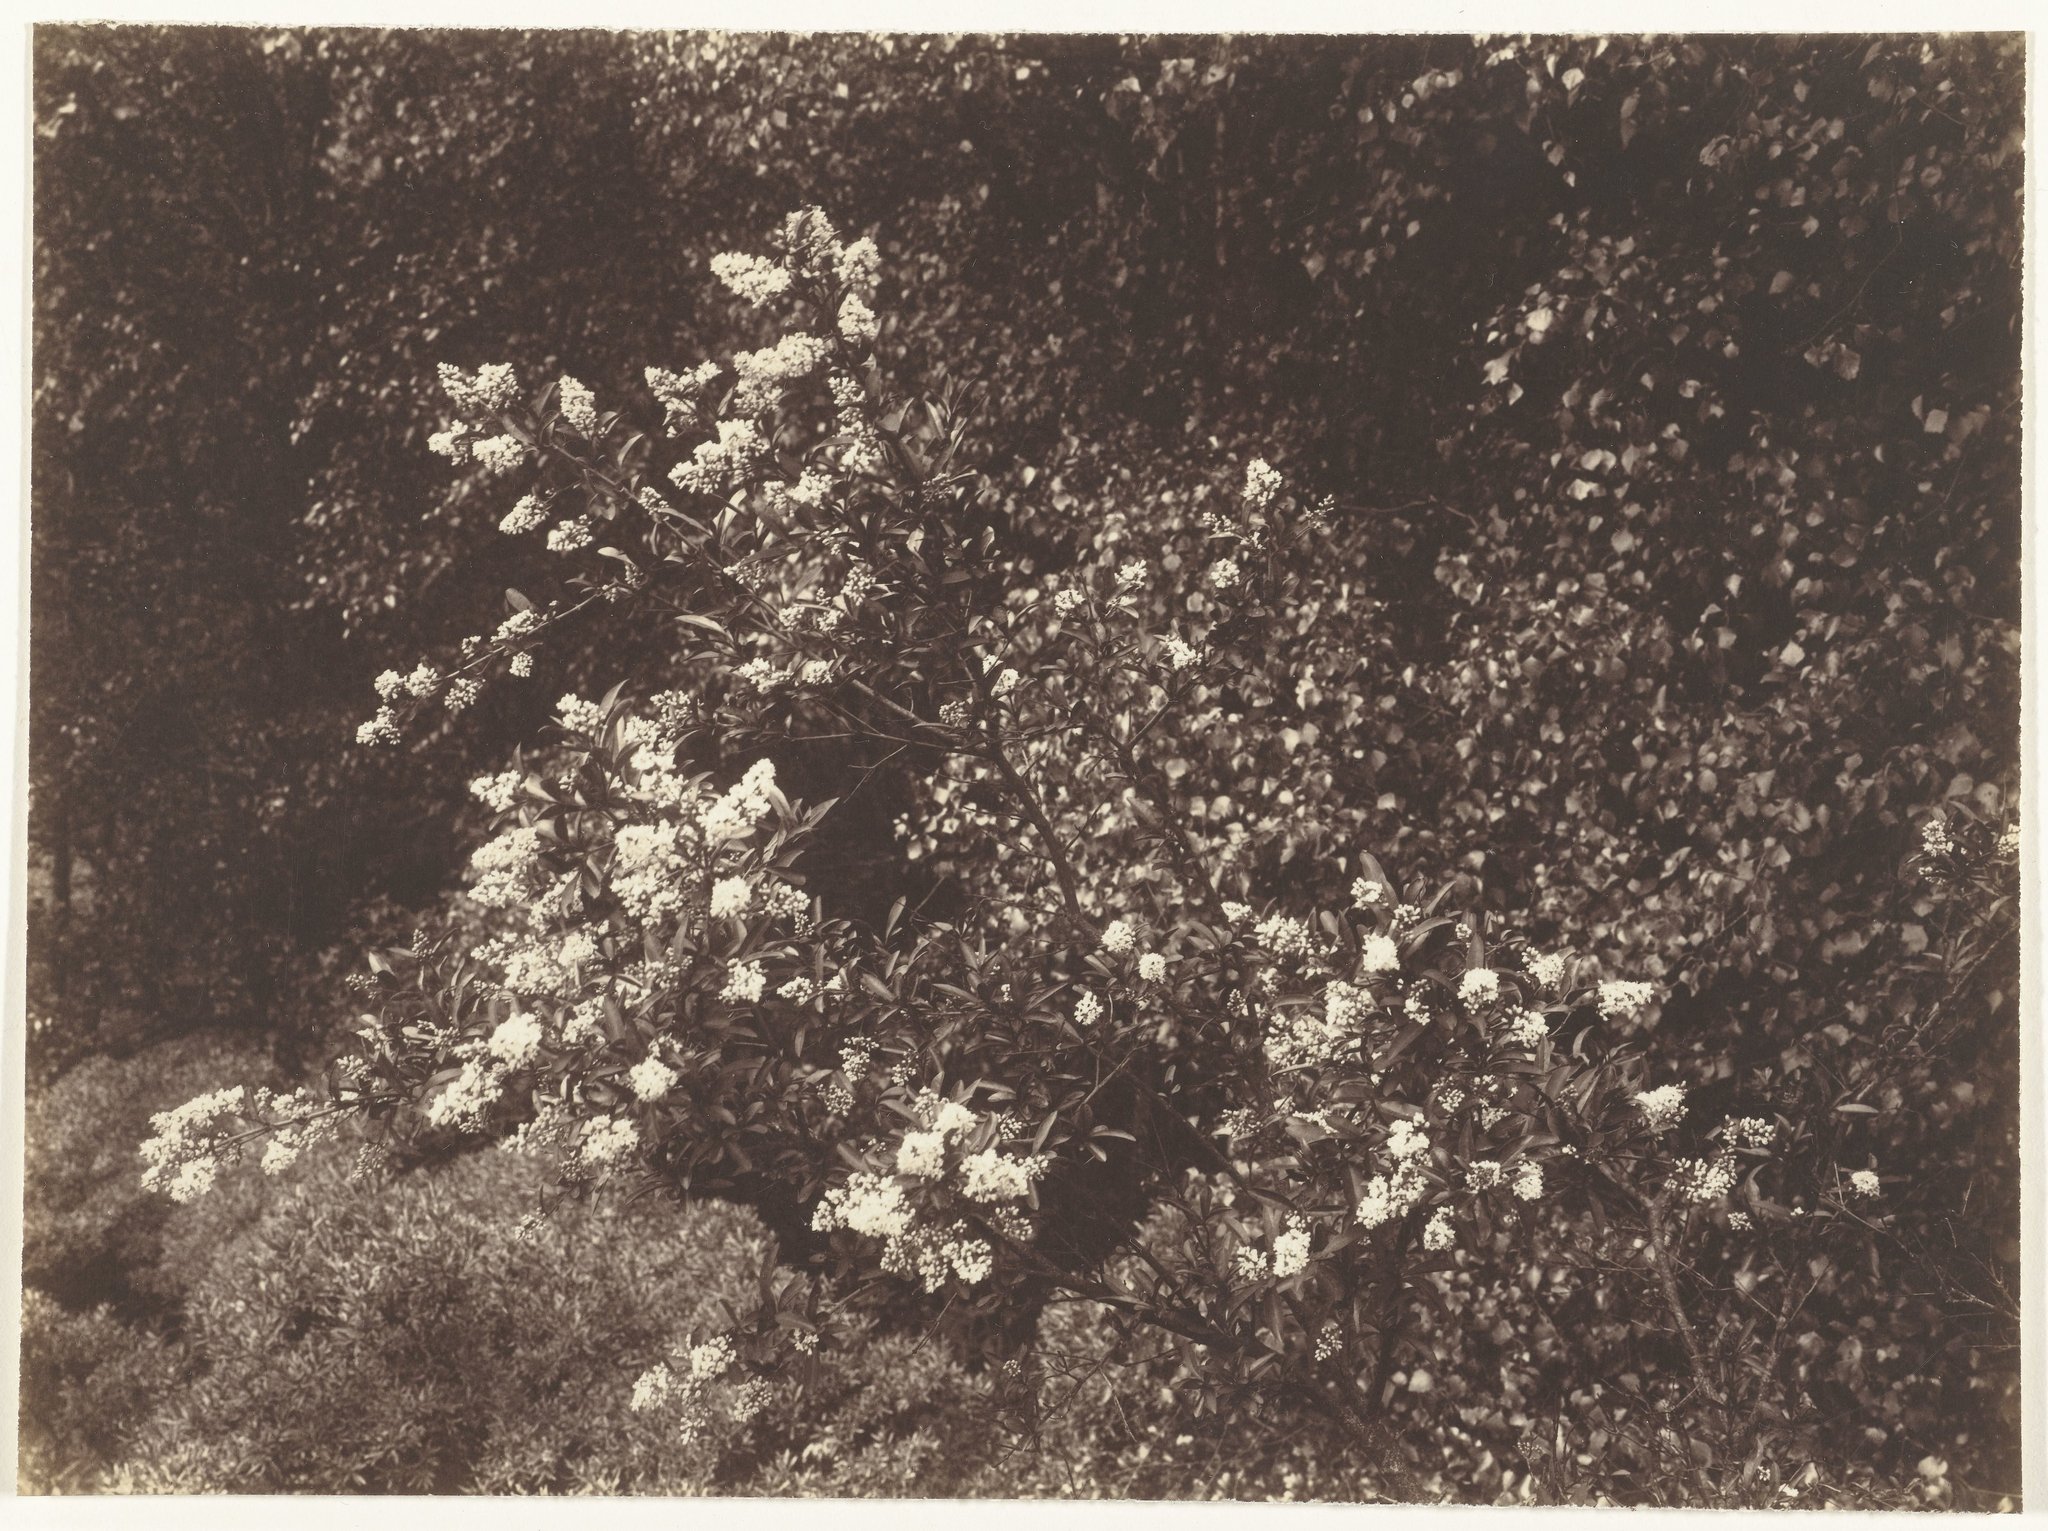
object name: photograph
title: Struik in bloei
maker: richard tepe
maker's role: fotograaf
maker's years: 1864-1952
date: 1900-1930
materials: photographic support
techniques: albumen print, salted paper print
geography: netherlands